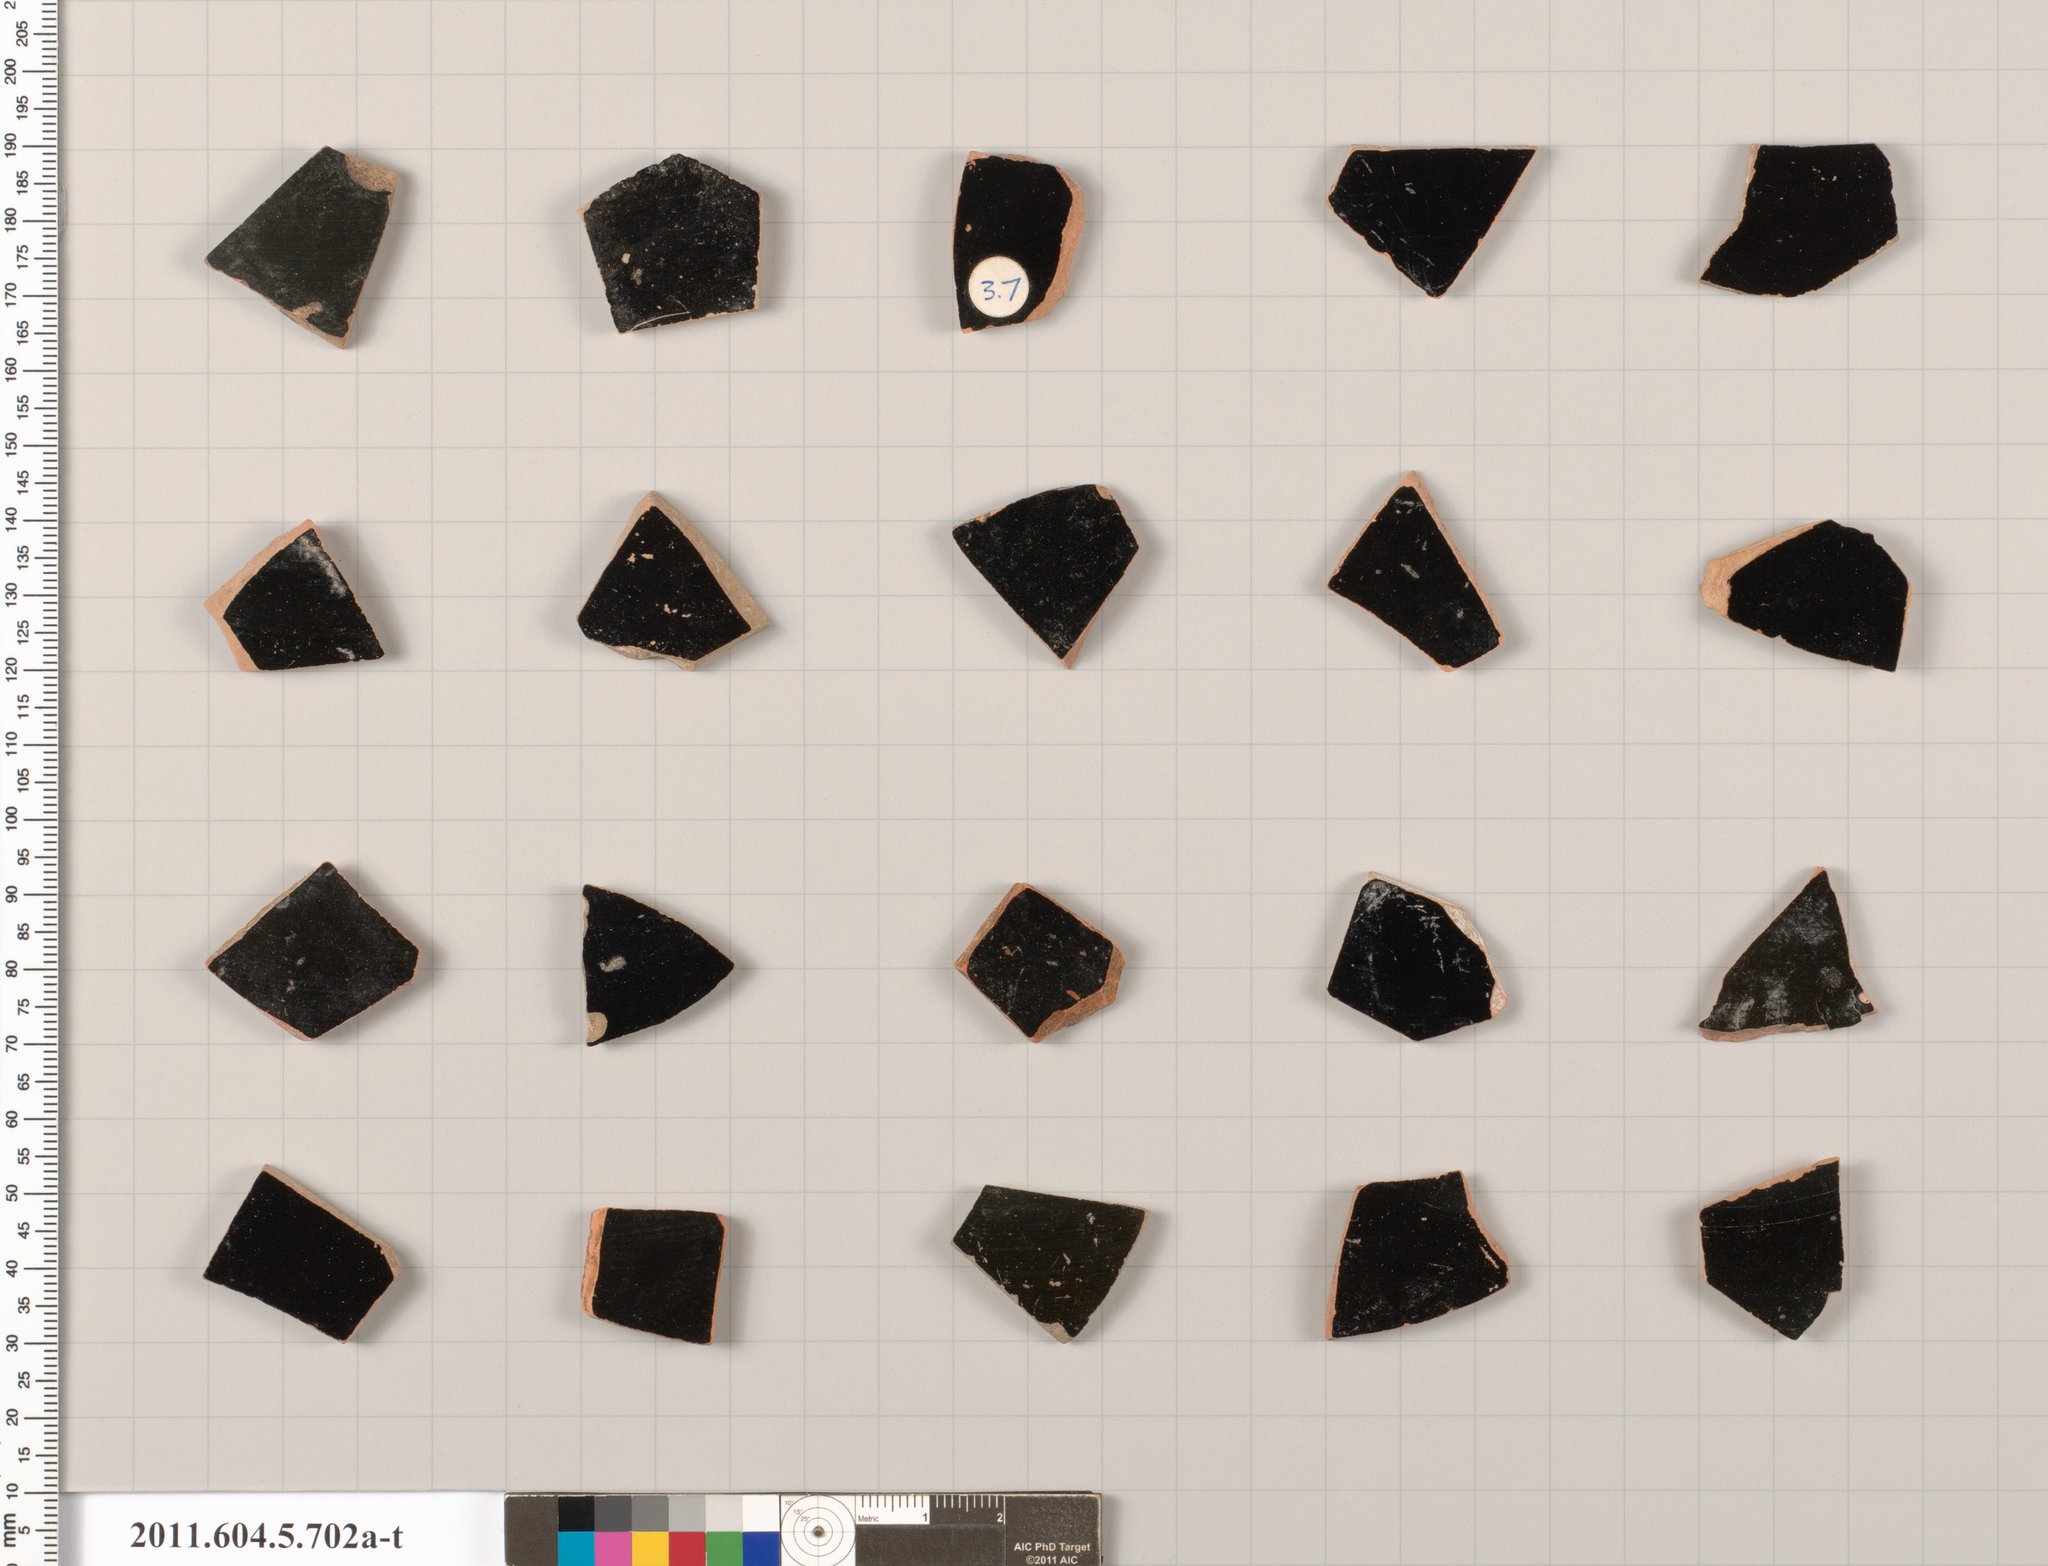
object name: kylix fragment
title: Terracotta fragments of kylikes (drinking cups)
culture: greek, attic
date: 600-401 BCE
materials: terracotta